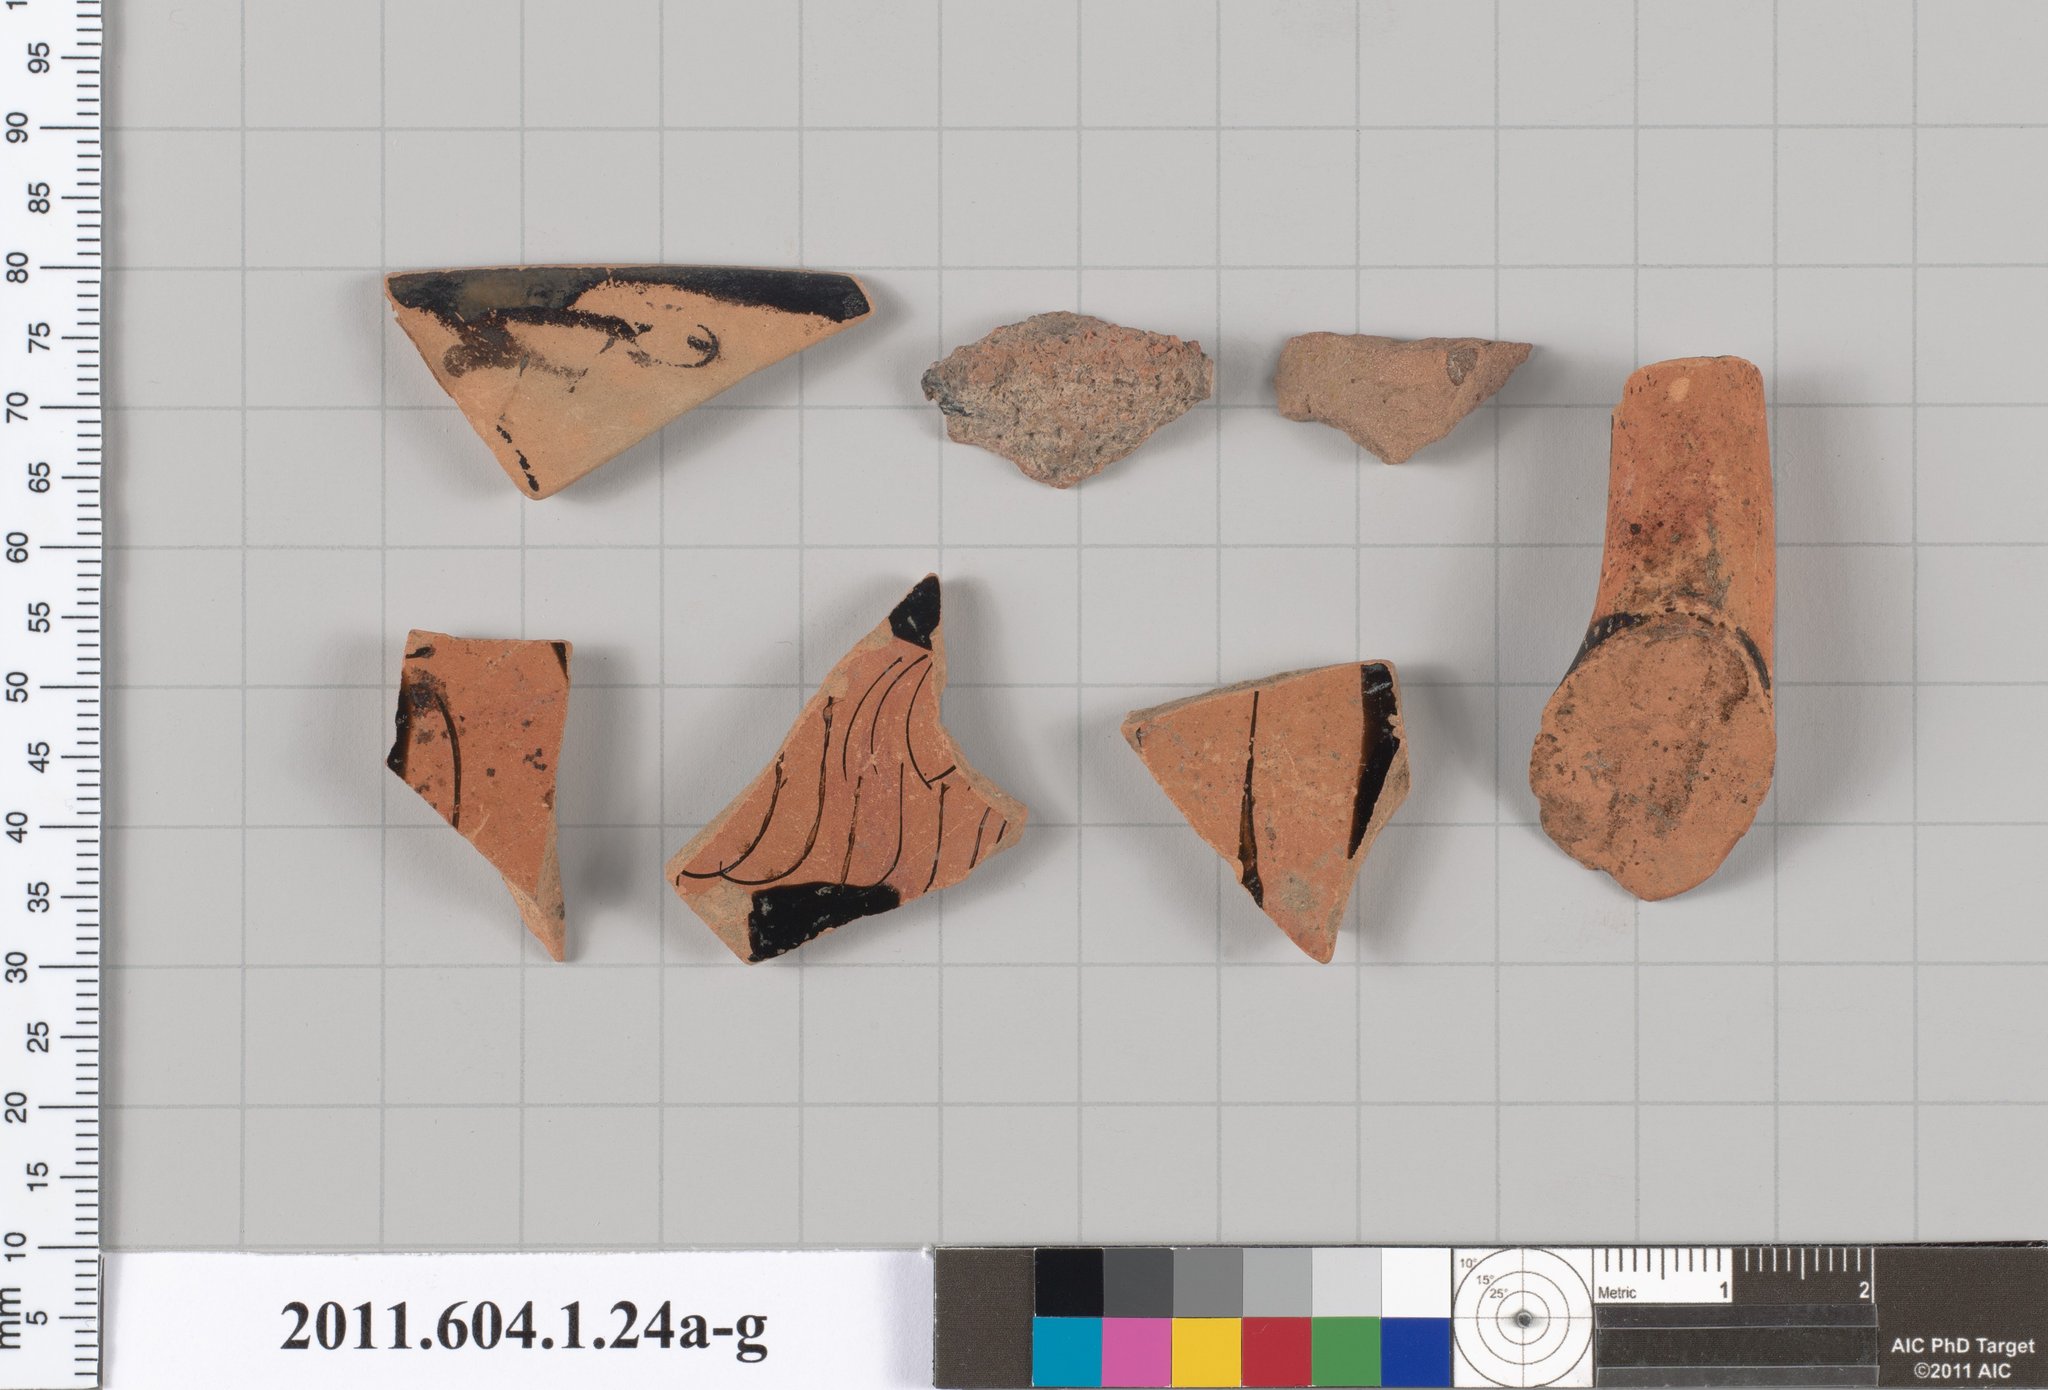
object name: kylix fragment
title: Terracotta fragments of kylikes (drinking cups)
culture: greek, attic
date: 500-501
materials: terracotta